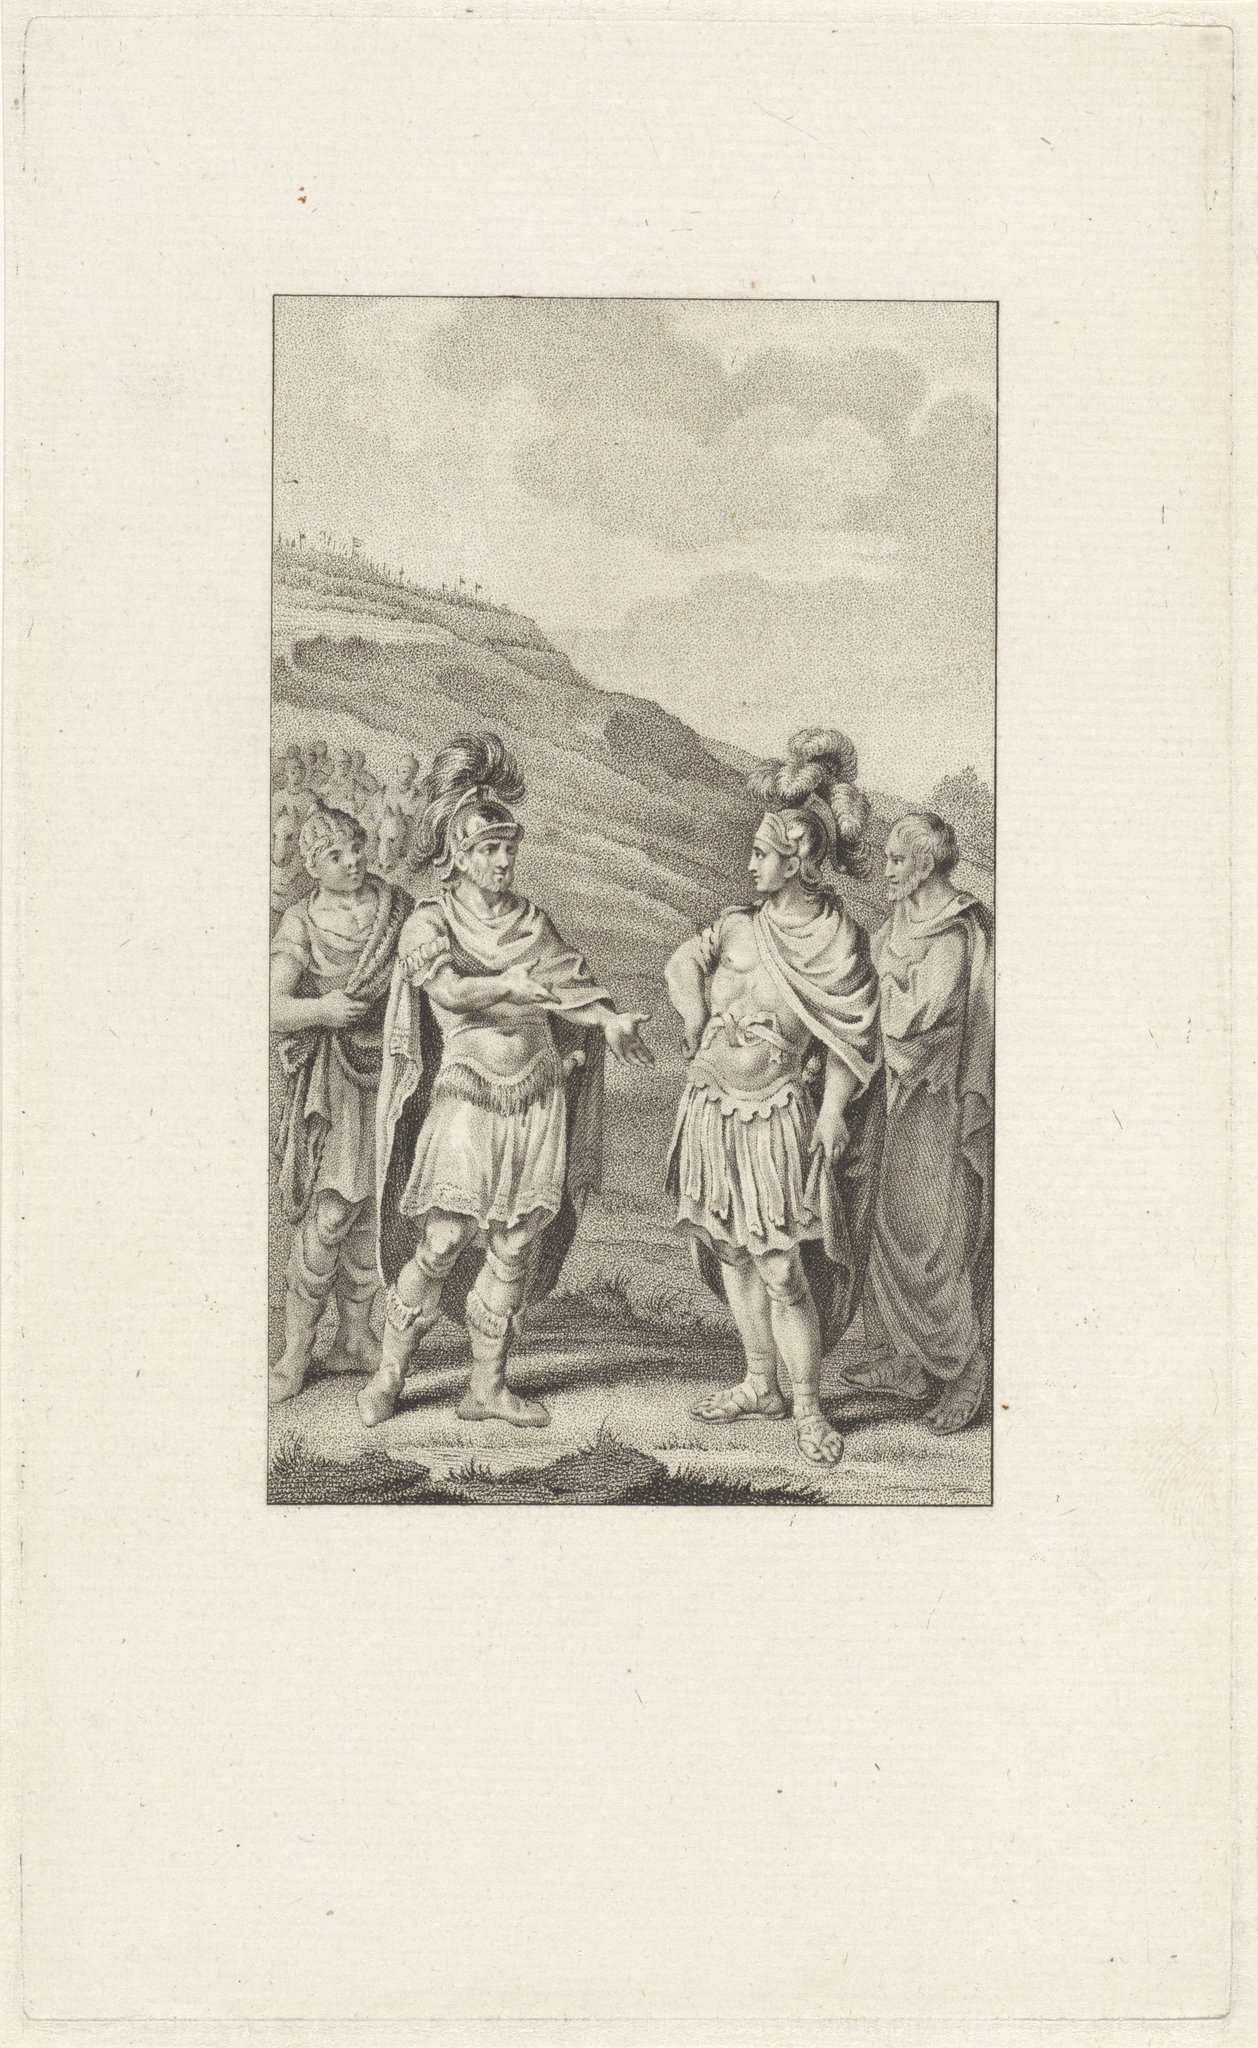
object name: print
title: Ontmoeting tussen Scipio en Hannibal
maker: ludwig gottlieb portman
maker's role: print maker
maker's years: 1772-1828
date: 1796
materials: paper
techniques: stippled etching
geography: amsterdam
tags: the meeting of scipio and hannibal before the battle of zama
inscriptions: collector's mark: Lugt 2228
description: Definitieve staat van deze prent gebruikt als illustratie in: Stuart, Martinus. Romeinsche geschiedenissen, deel VIII, p. 318. Amsterdam: Johannes Allart, 1796.